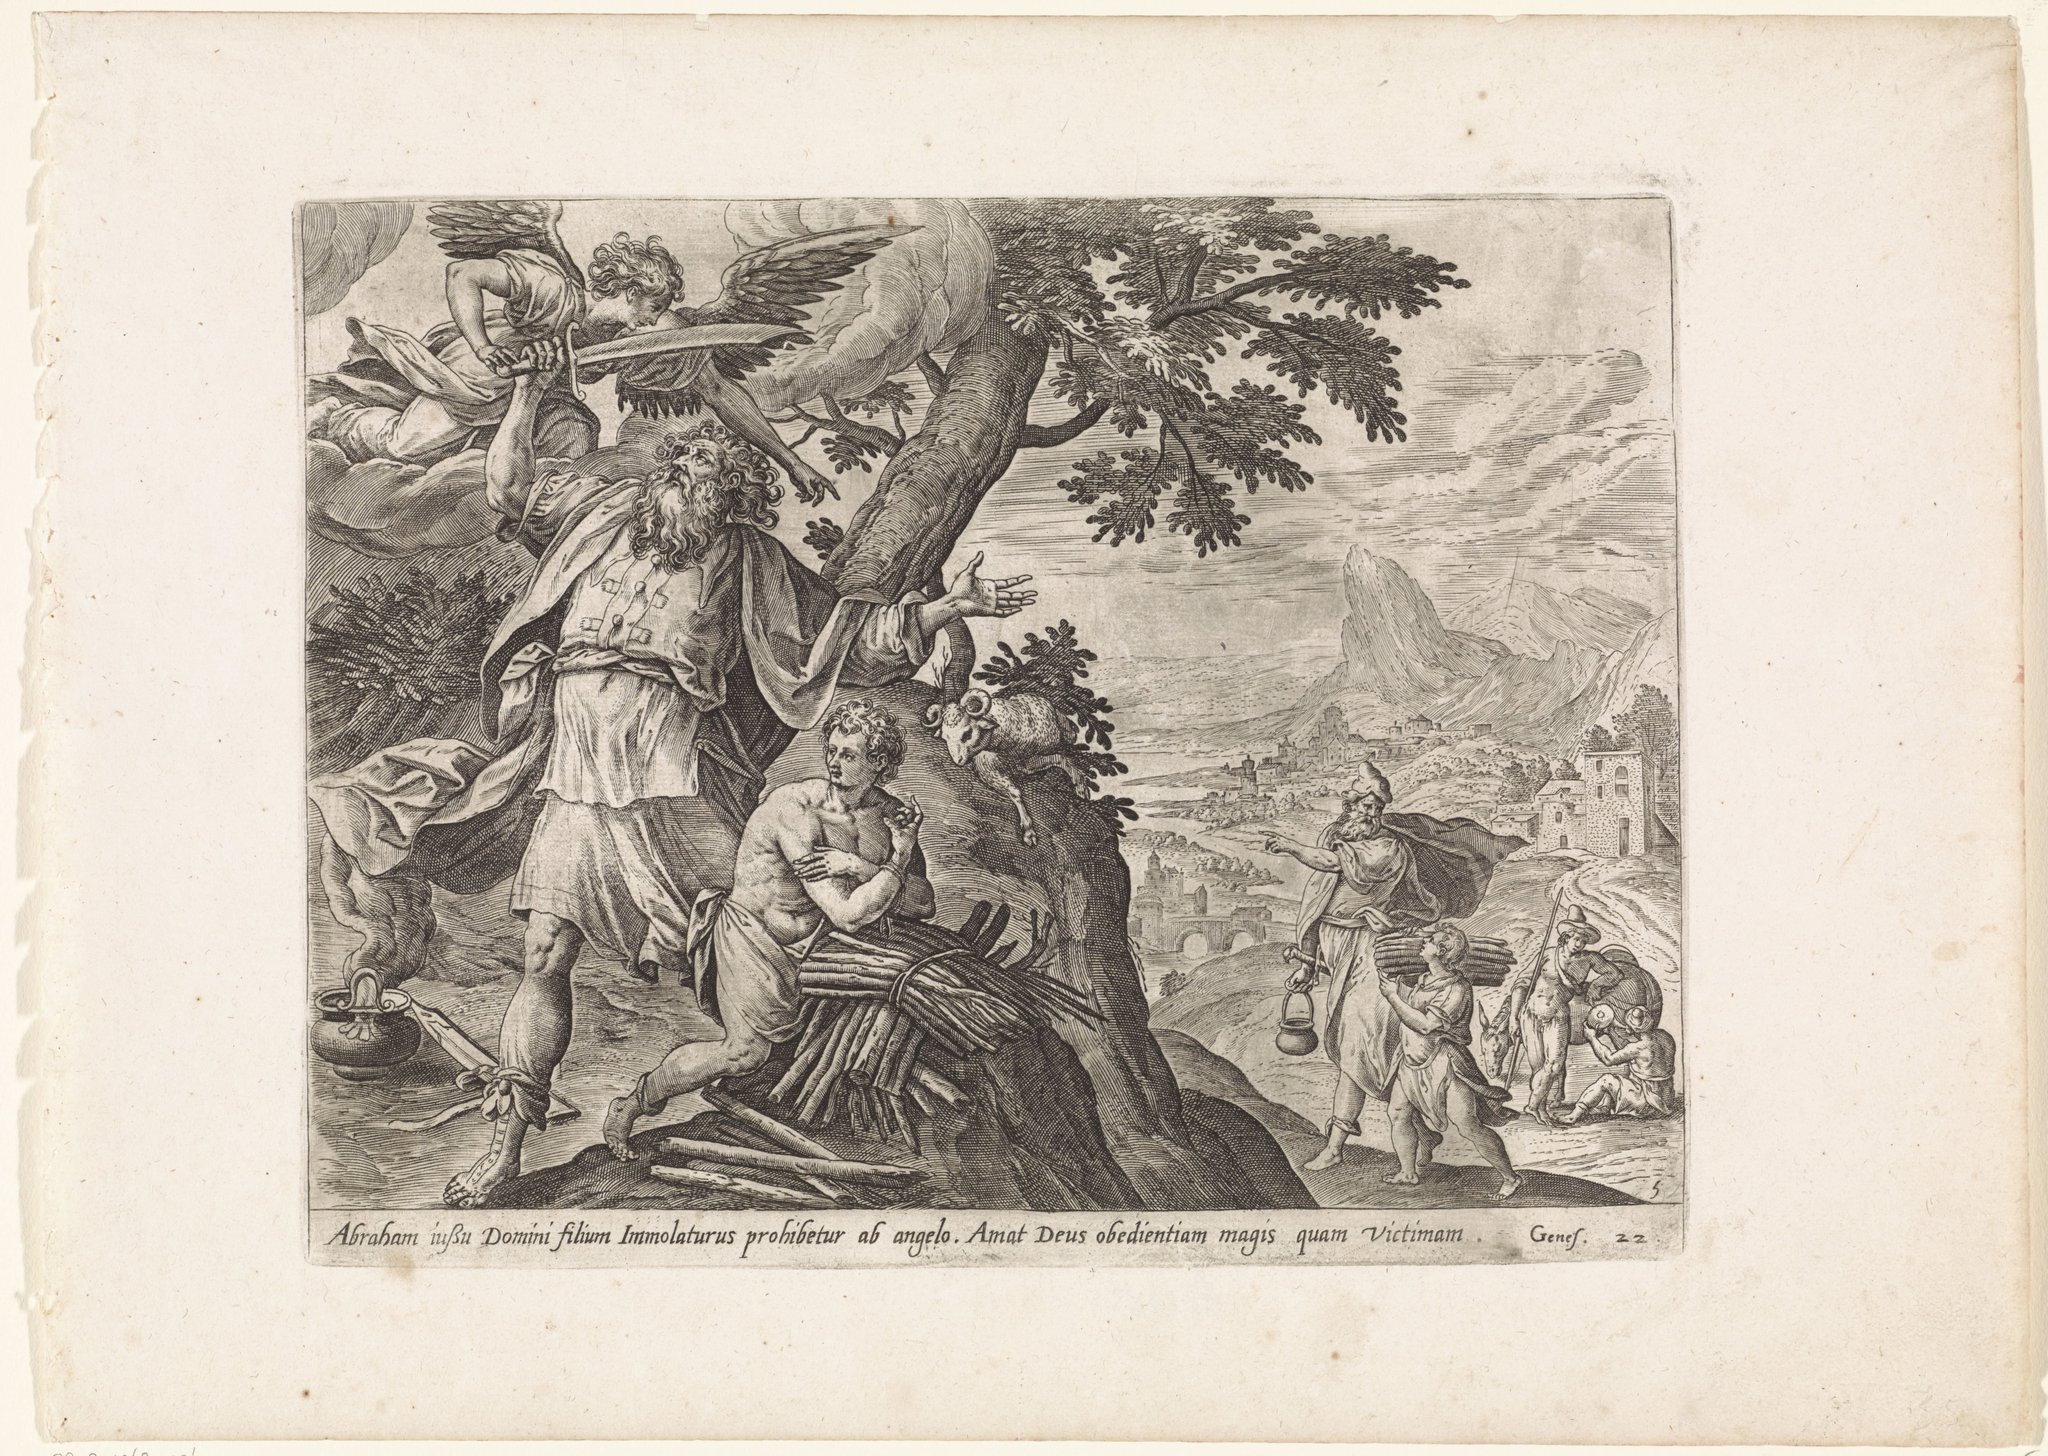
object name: print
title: Theatrum biblicum (...)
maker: adriaen collaert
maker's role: draughtsman, print maker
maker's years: 1560-1618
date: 1585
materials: paper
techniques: engraving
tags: the servants are left behind while abraham and isaac (usually carrying wood) climb the mountain, when abraham has his hand raised to kill isaac, an angel restrains abraham's hand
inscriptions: collector's mark: Lugt 2760, collector's mark: Lugt 2228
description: Prent mogelijk gebruikt in: Thesaurus sacrarum historiaru[m] veteris (et novi) testame[n]ti, elega[n]tissimis imaginibus expressu[m] excelle[n]tissimoru[m] in hac arte viroru[m] opera : nu[n]c primu[m] in luce[m] editus. Antwerpen: Gerard de Jode, 1585. Of prent gebruikt in: Theatrum biblicum : hoc est historiae sacrae veteris et novi testamenti tabulis aeneis expressae. Opus praesentatissimorum huius ac superioris seculi pictorum atque sculptorum, summo studio conquisitum et in lucem editum. Amsterdam: Claes Jansz. Visscher, 1643.